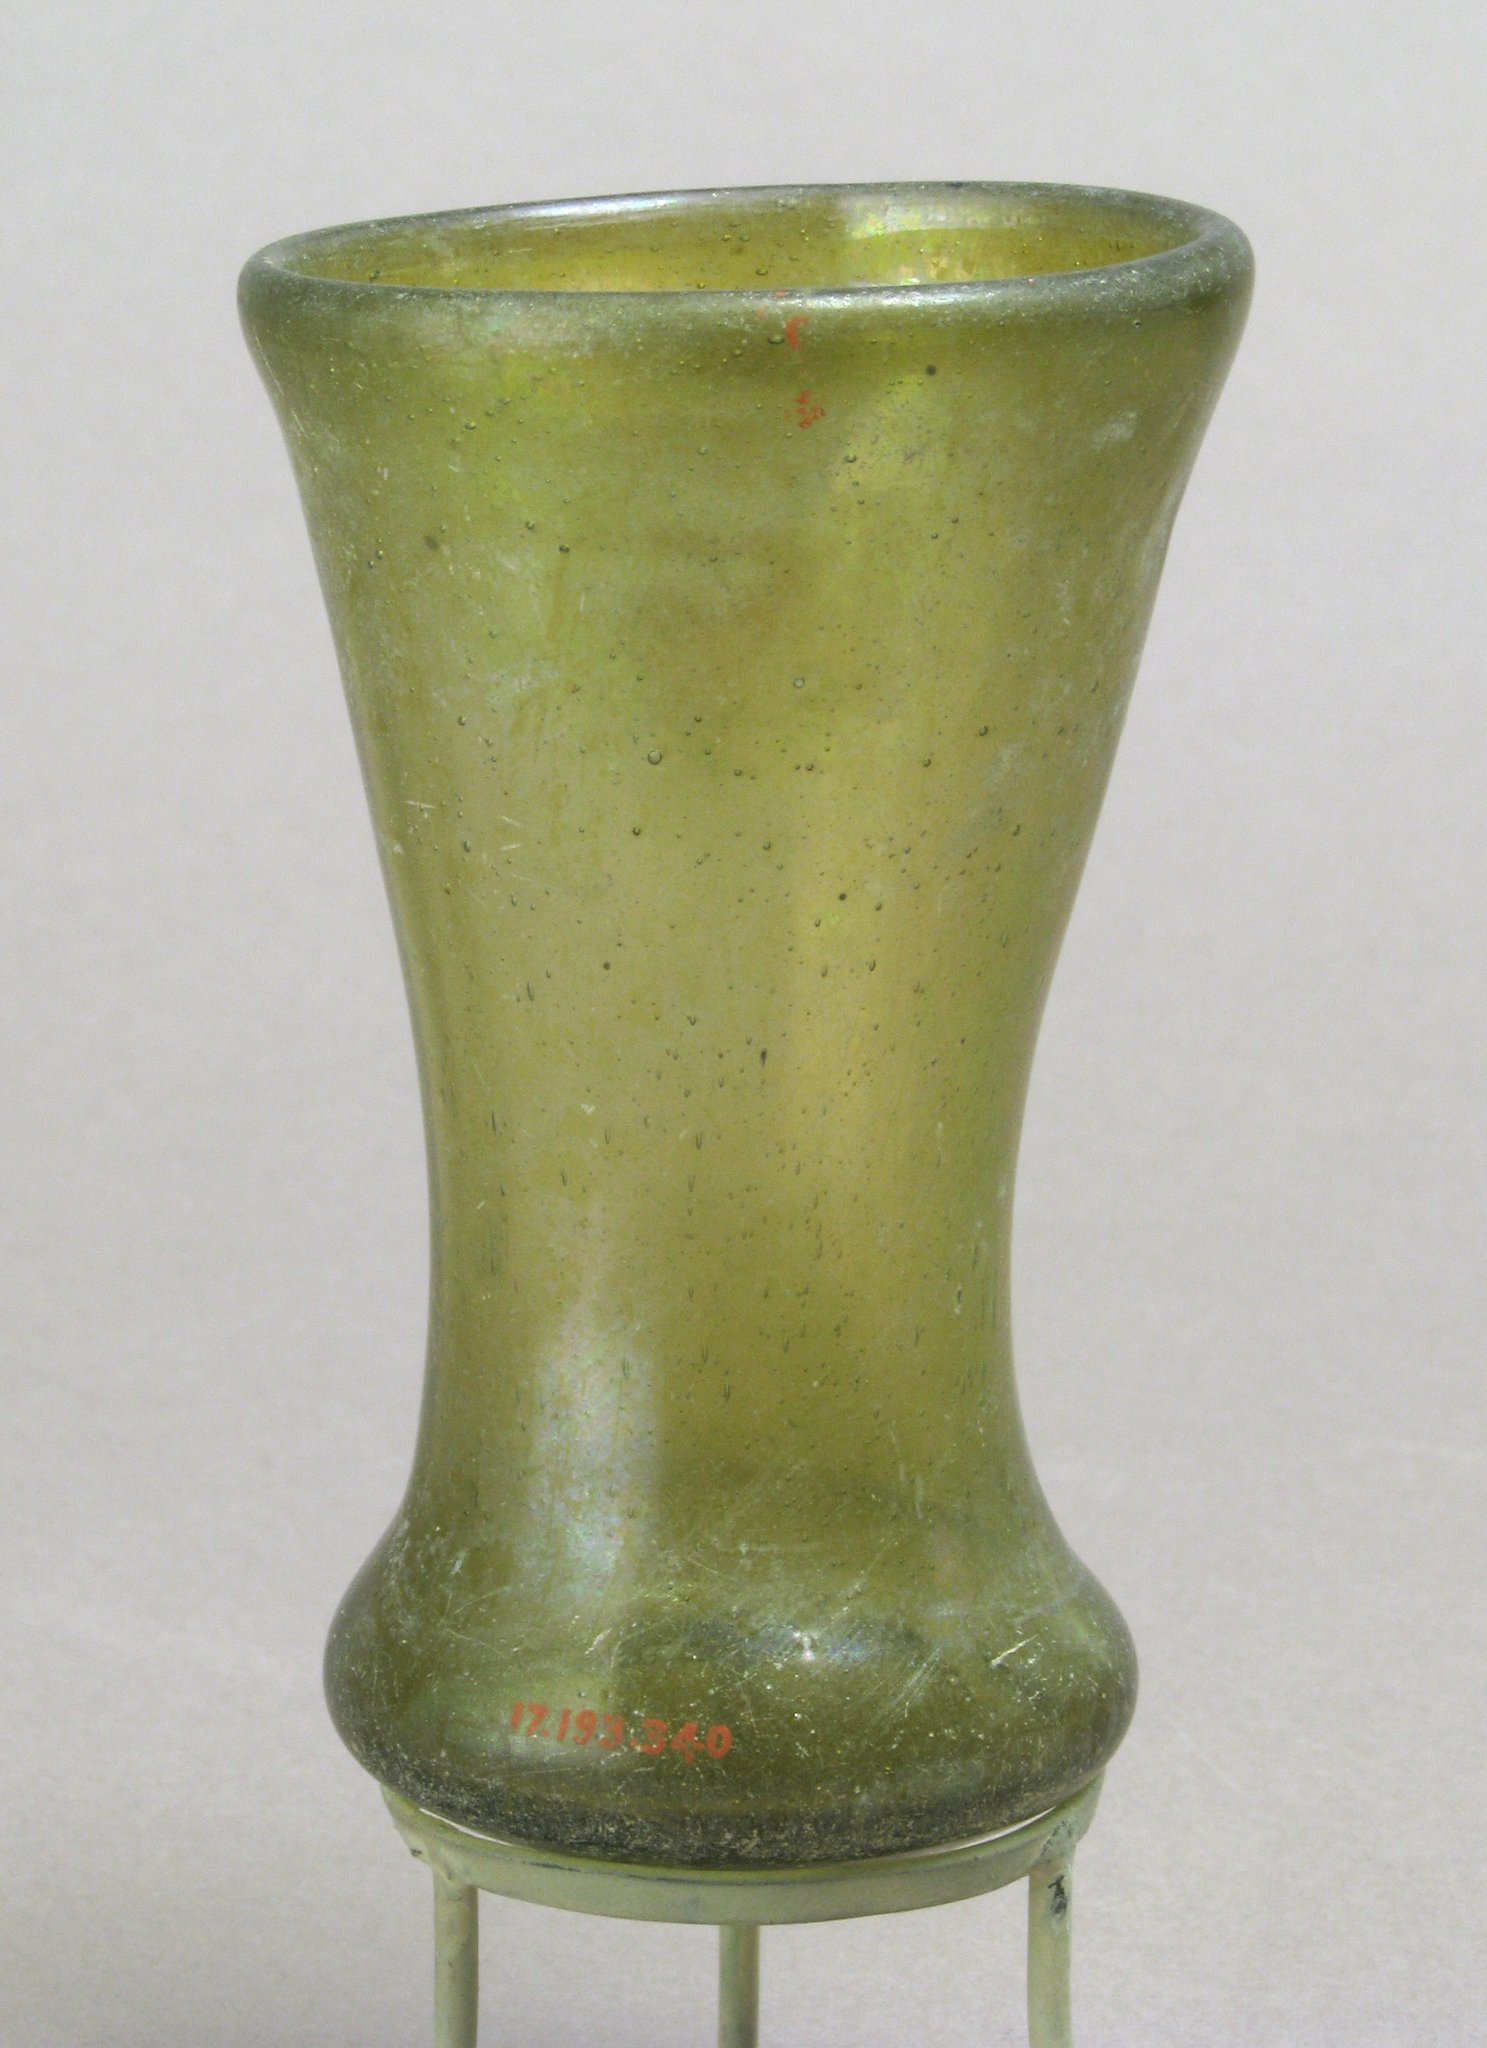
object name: beaker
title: Bell Beaker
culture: frankish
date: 501-700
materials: glass